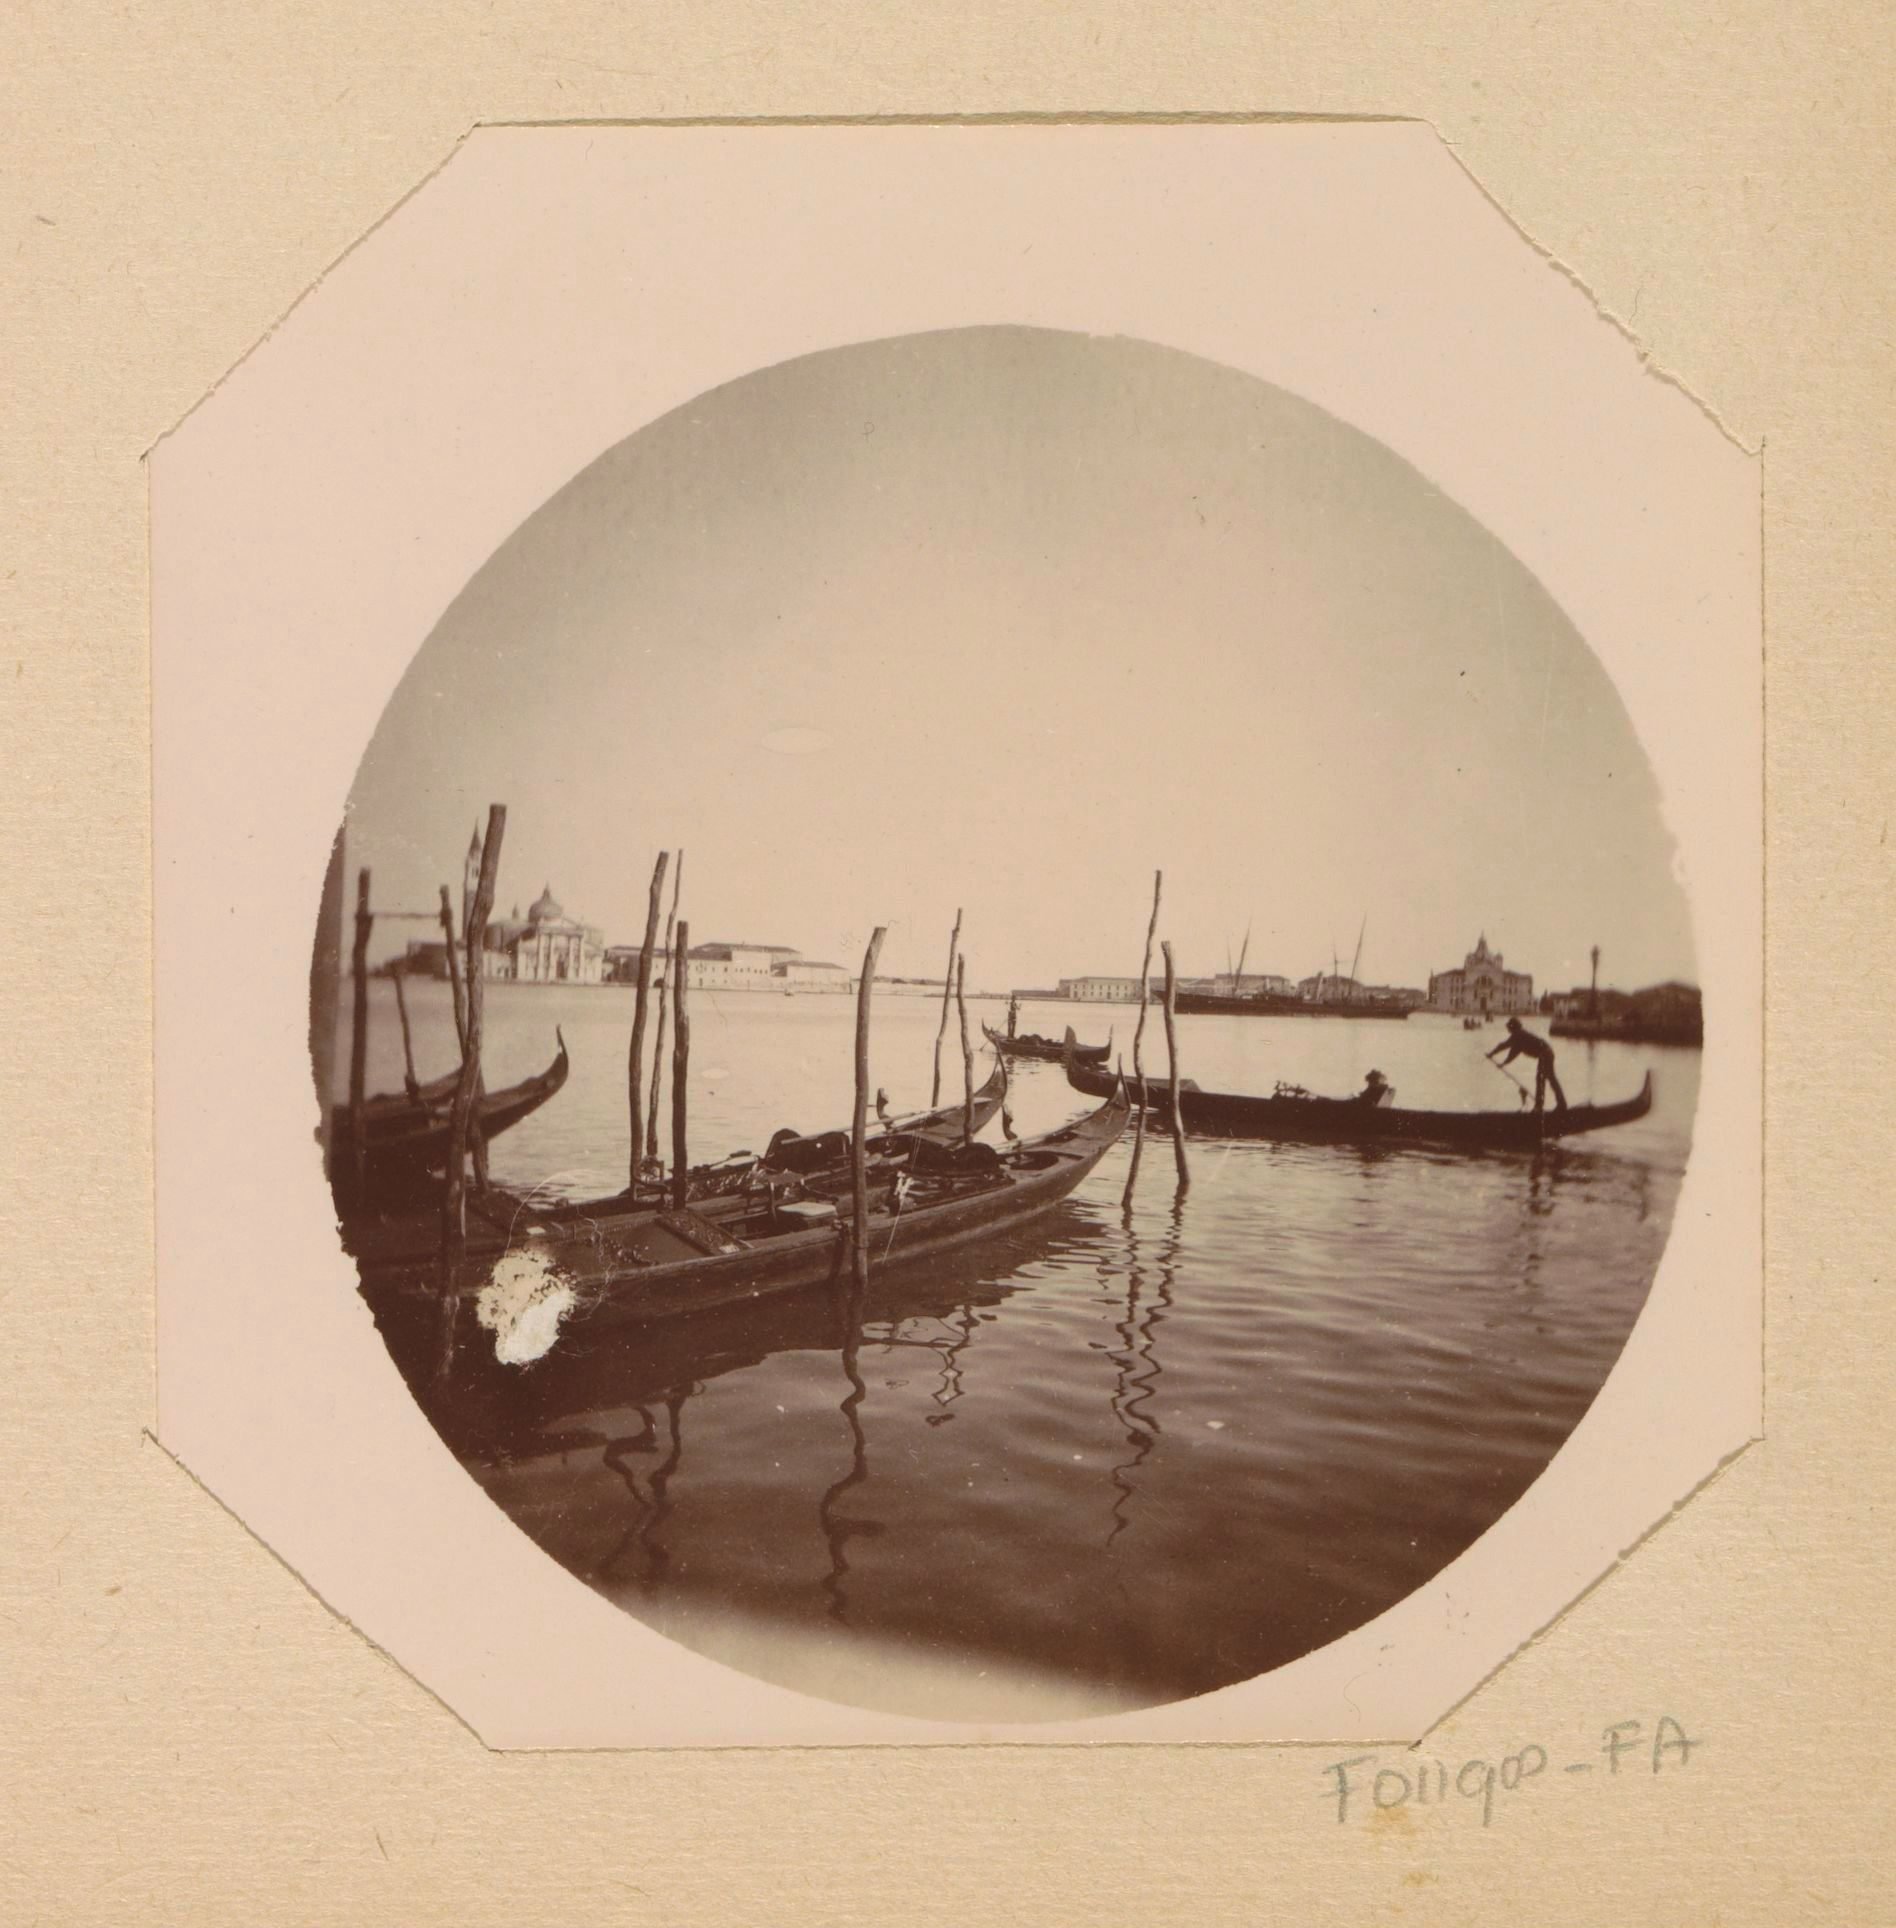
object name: album leaf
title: Venetië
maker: johanna margaretha piek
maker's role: fotograaf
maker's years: 1870-1947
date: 1889-1893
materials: paper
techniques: gelatin silver print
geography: venice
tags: gondola